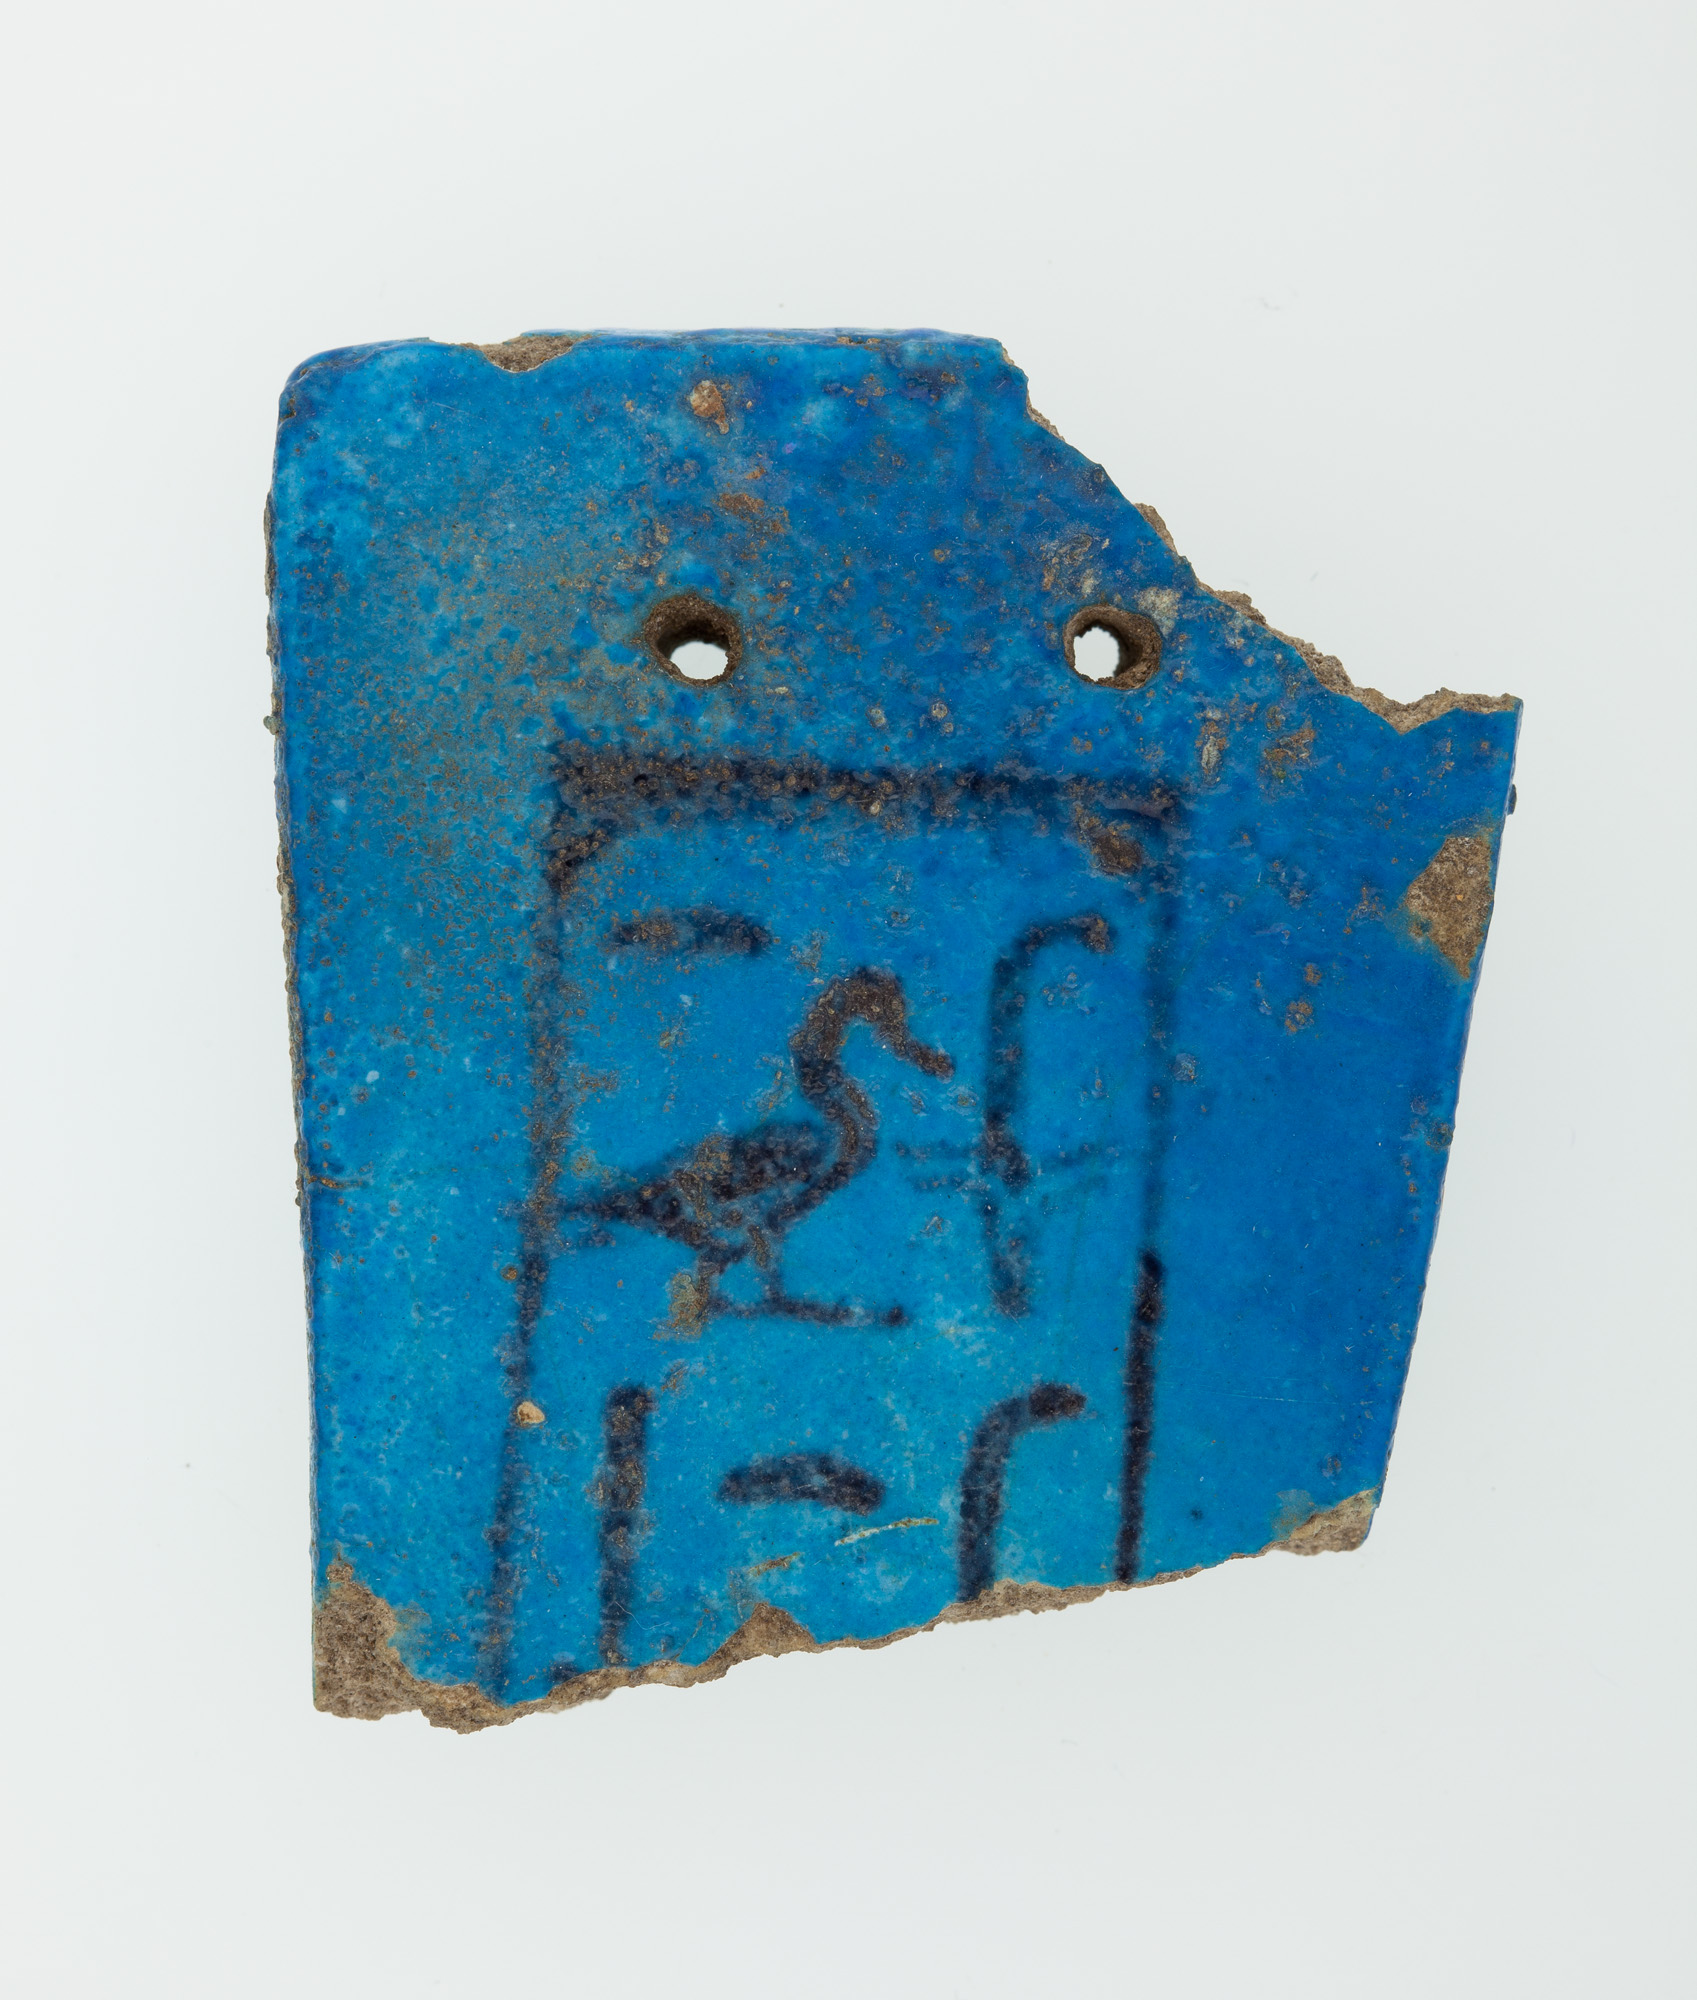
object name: menat fragment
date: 1479-1458 BCE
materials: faience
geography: egypt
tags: hieroglyphs